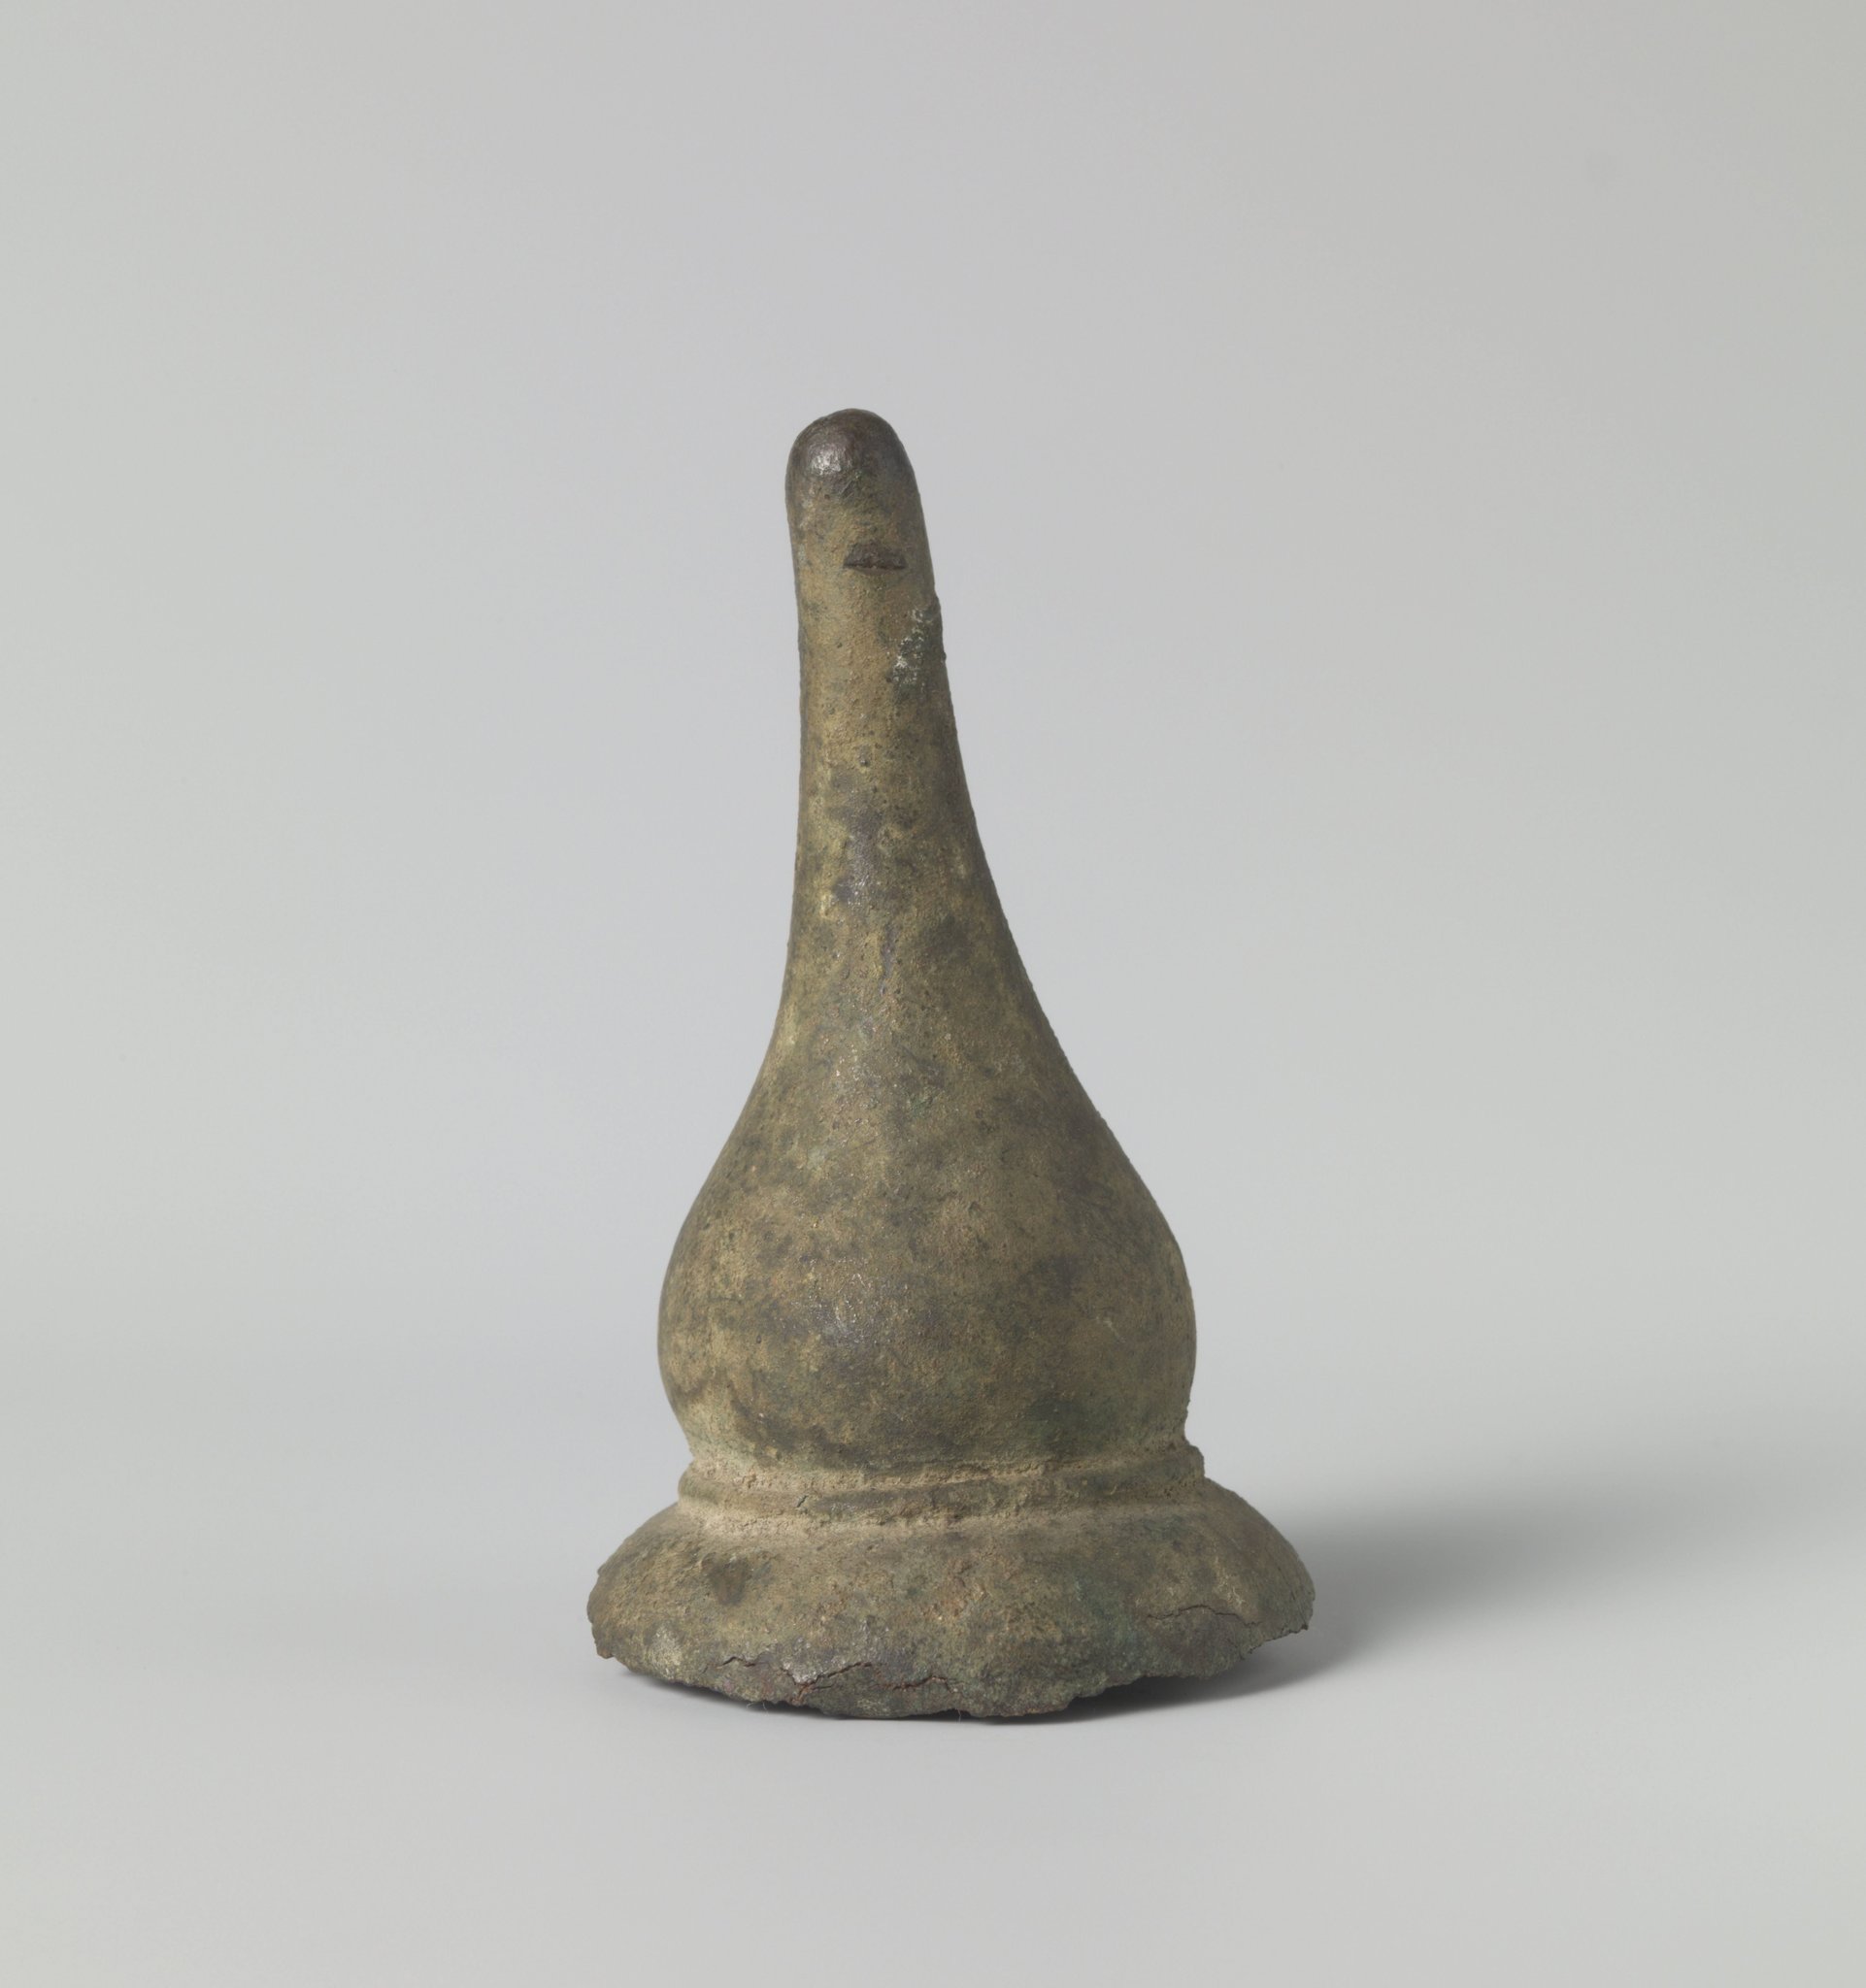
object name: stupa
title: Votiefstoepa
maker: Anonymous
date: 1600-1699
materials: bronze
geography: thailand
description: Votief-gave in de vorm van een kleine stupa; de onderzijde is afgebroken.